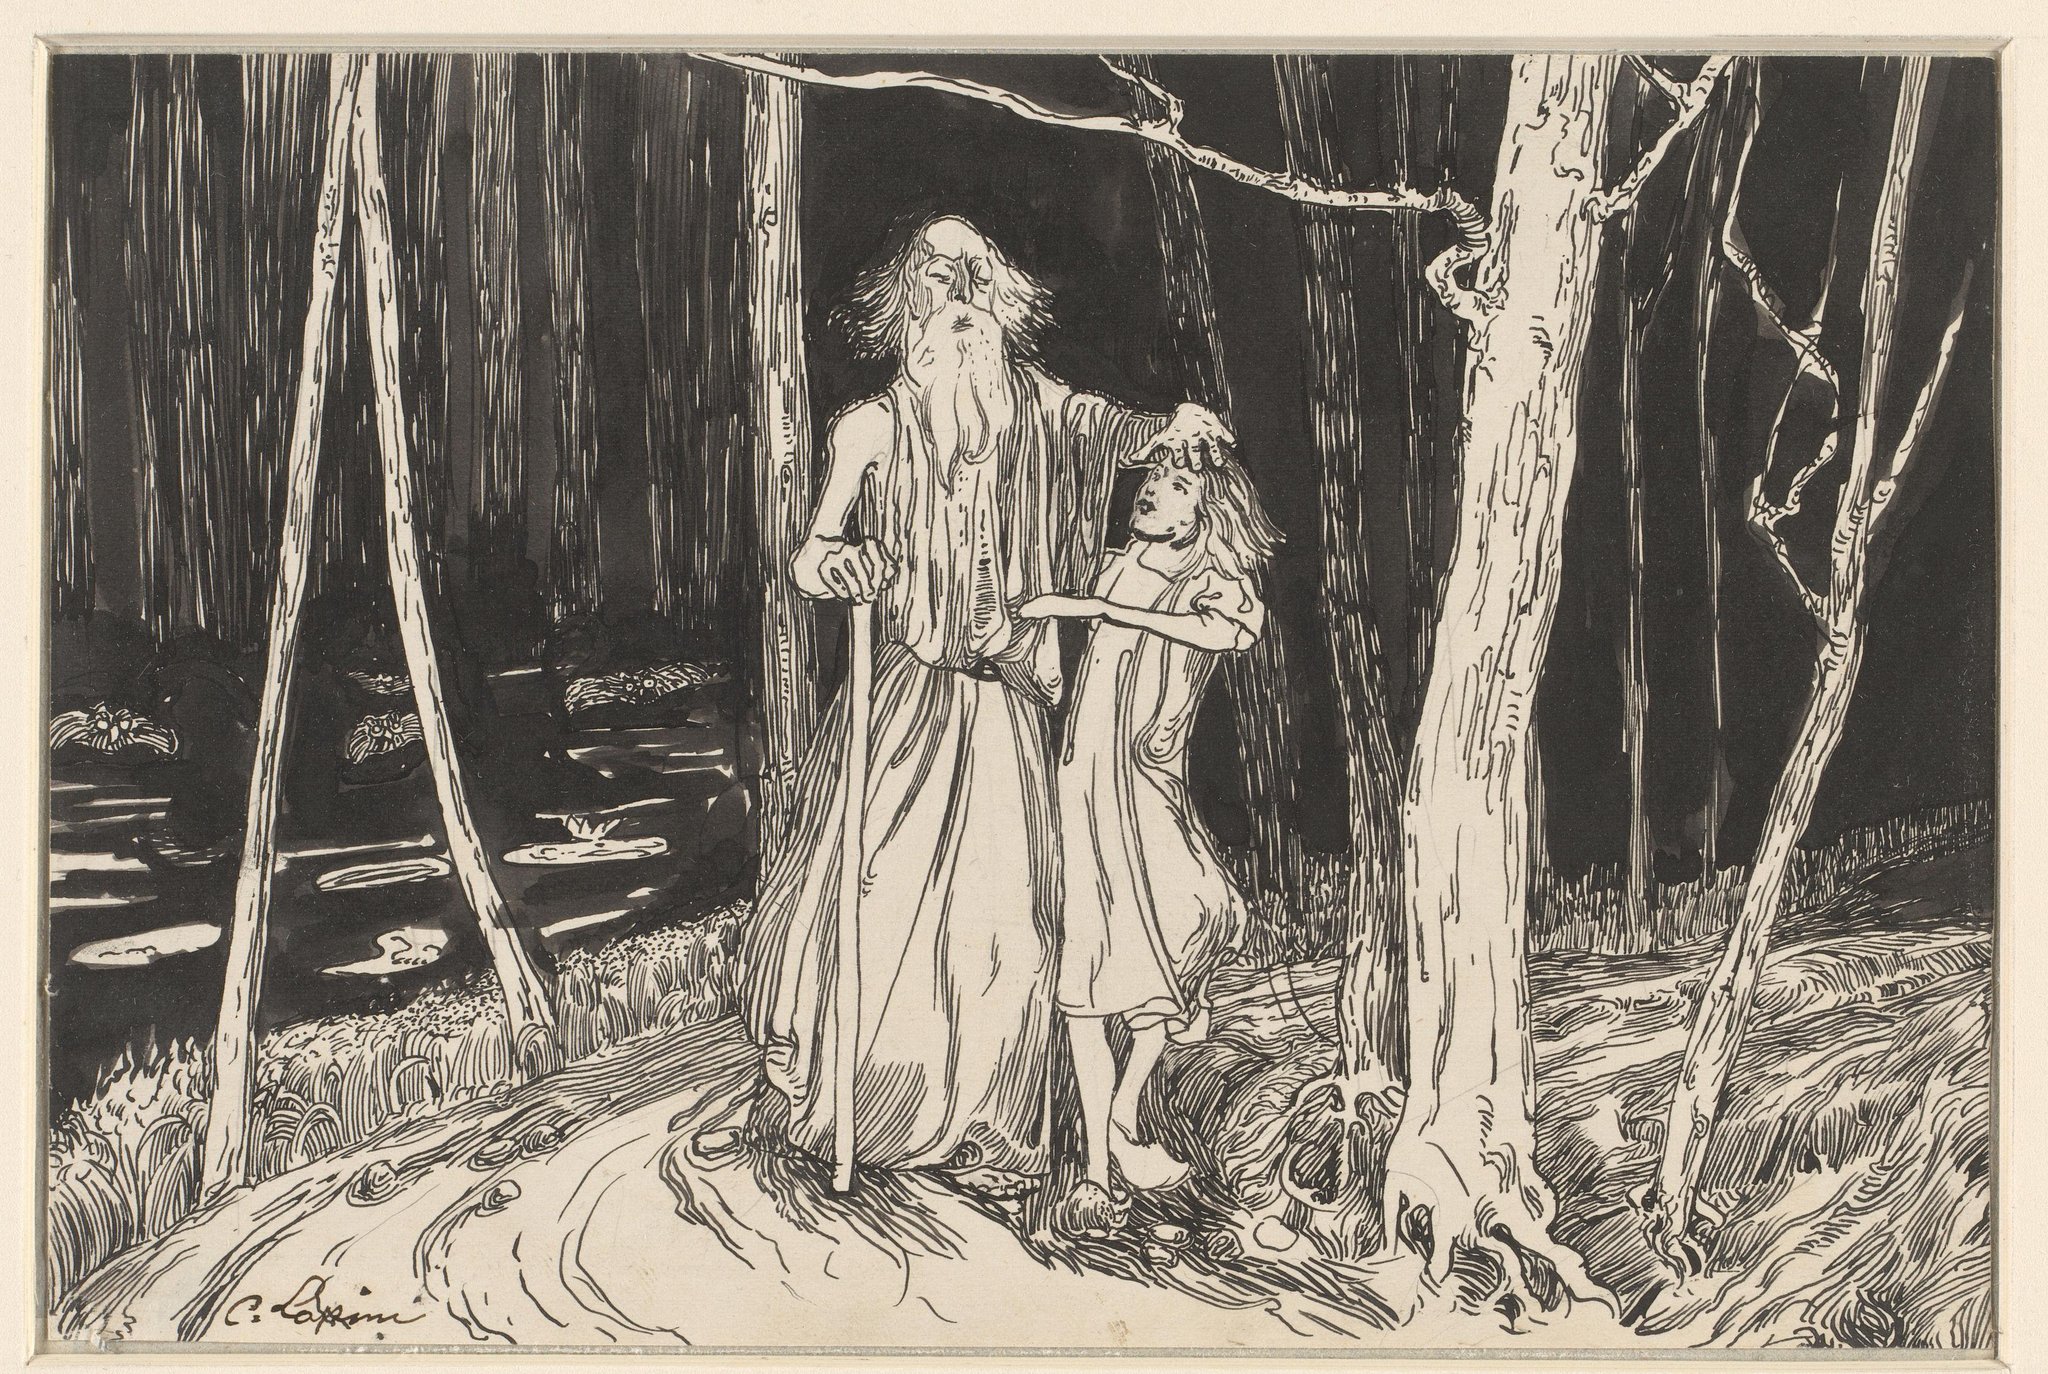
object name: drawing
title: Jongen die een oude blinde man door een bos leidt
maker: c. lapine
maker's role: draughtsman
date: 1897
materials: ink, paper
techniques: brush, pen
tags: blind, blindness